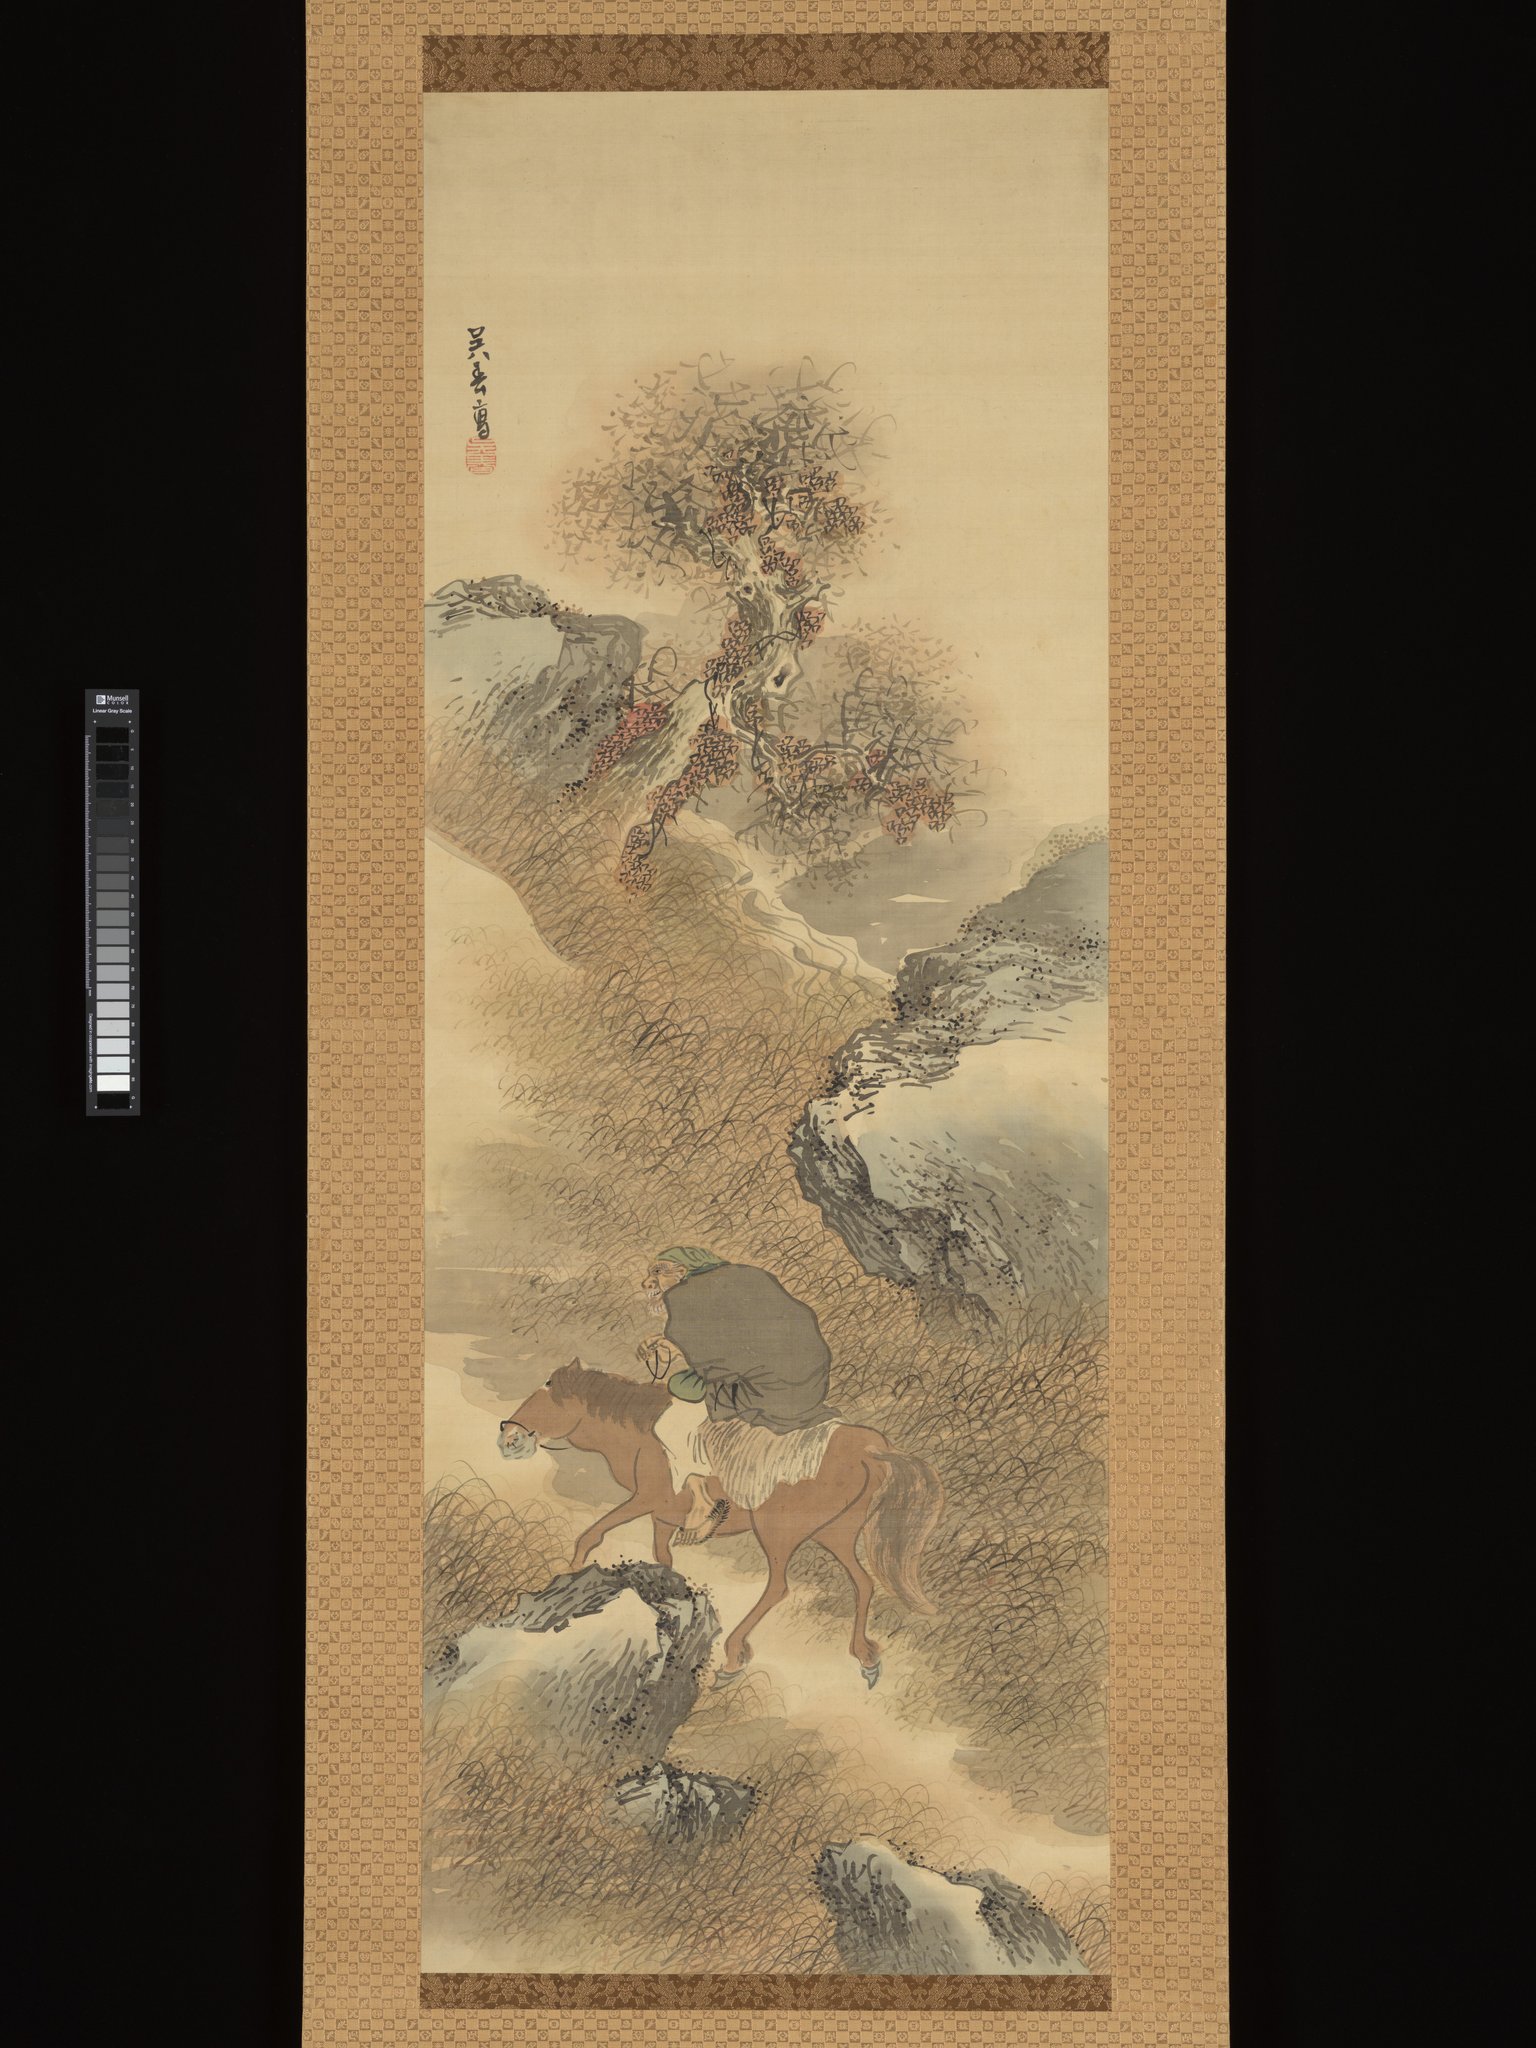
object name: hanging scroll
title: Herb Gatherer in the Mountains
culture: japanese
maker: go shun (matsumura gekkei)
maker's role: artist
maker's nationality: japanese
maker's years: 1752-1811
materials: ink, silk